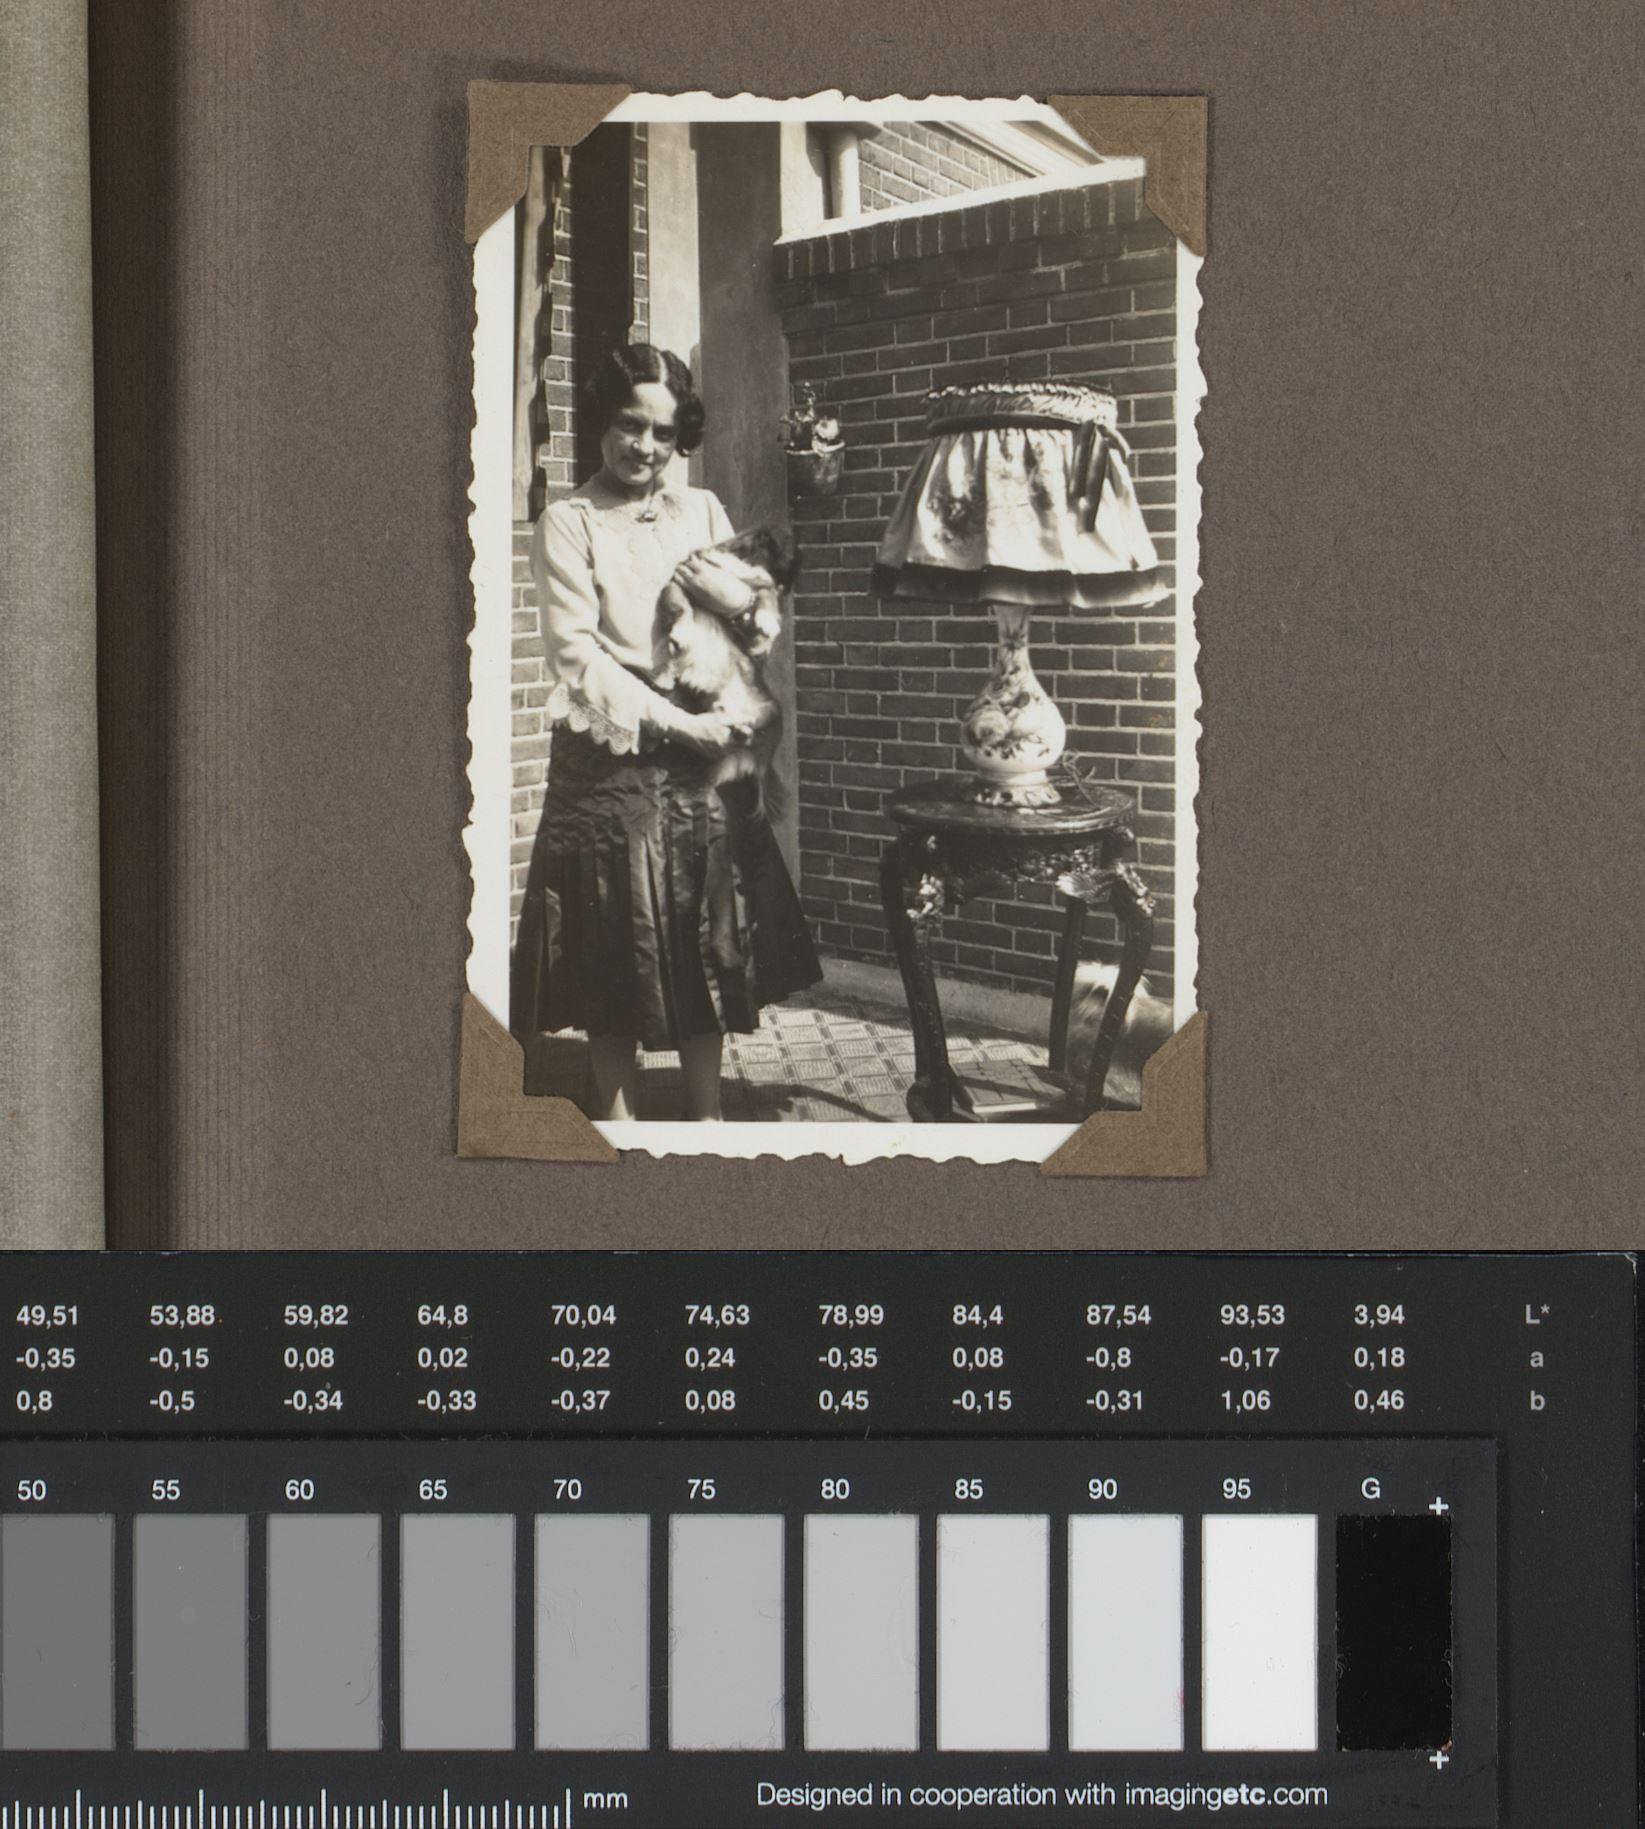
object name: photograph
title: Henriëtte Wassink met hond op balkon of in tuin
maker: Anonymous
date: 1930-1935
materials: paper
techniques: gelatin silver print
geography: netherlands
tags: batavia, henriëtte wassink, adult woman, dog, netherlands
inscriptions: number: ‘1097’